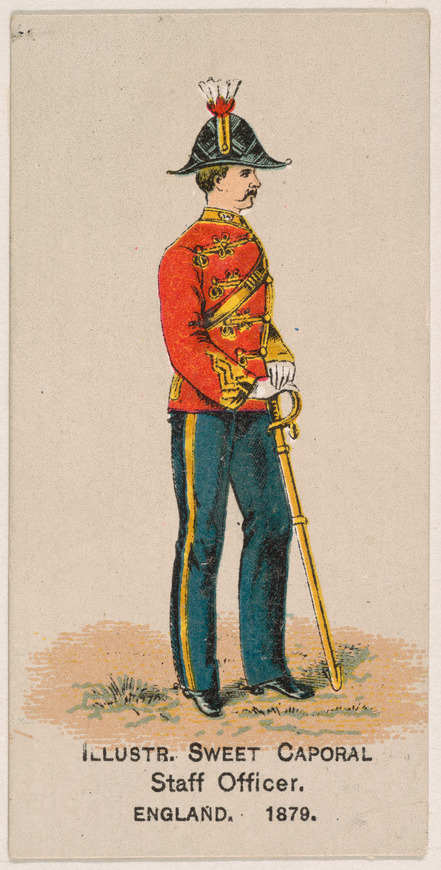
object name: print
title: Staff Officer, England, 1879, from the Military Series (N224) issued by Kinney Tobacco Company to promote Sweet Caporal Cigarettes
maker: kinney brothers tobacco company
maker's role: publisher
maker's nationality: american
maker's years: 1869-2011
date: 1888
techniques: color lithograph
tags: military,men